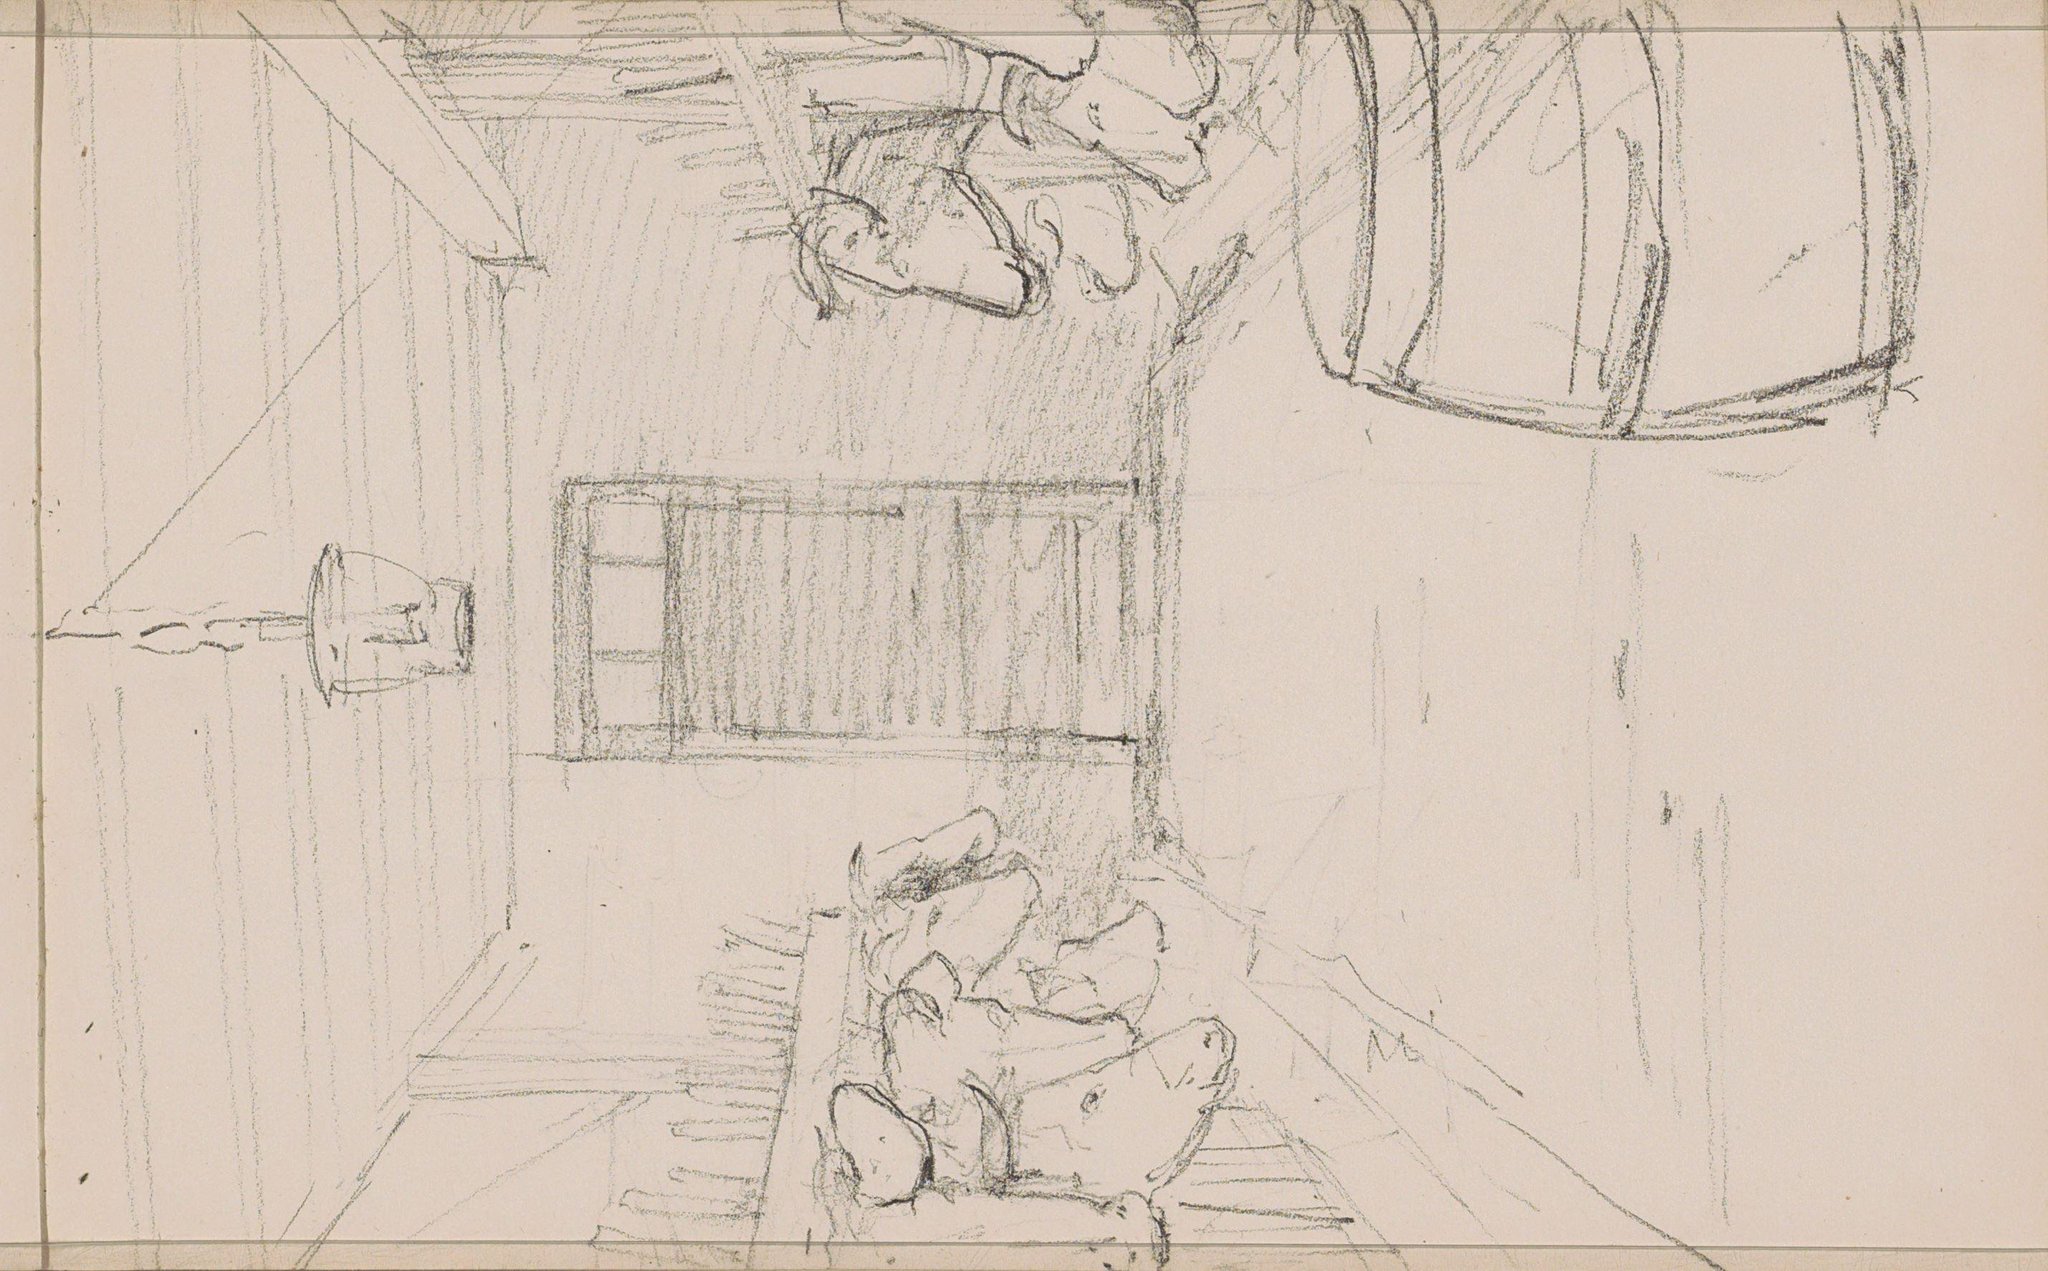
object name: sketchbook leaf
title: Interieur van een stal met twee rijen koeien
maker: a.a.l. de grammont-hubrecht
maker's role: draughtsman, painter, print maker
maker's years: 1855-1913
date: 1865-1913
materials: chalk, paper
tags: wooden container: barrel, cask, bucket, cow, stall, stable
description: Op de voorgrond een ton. Blad 10 recto uit een schetsboek met 28 bladen.